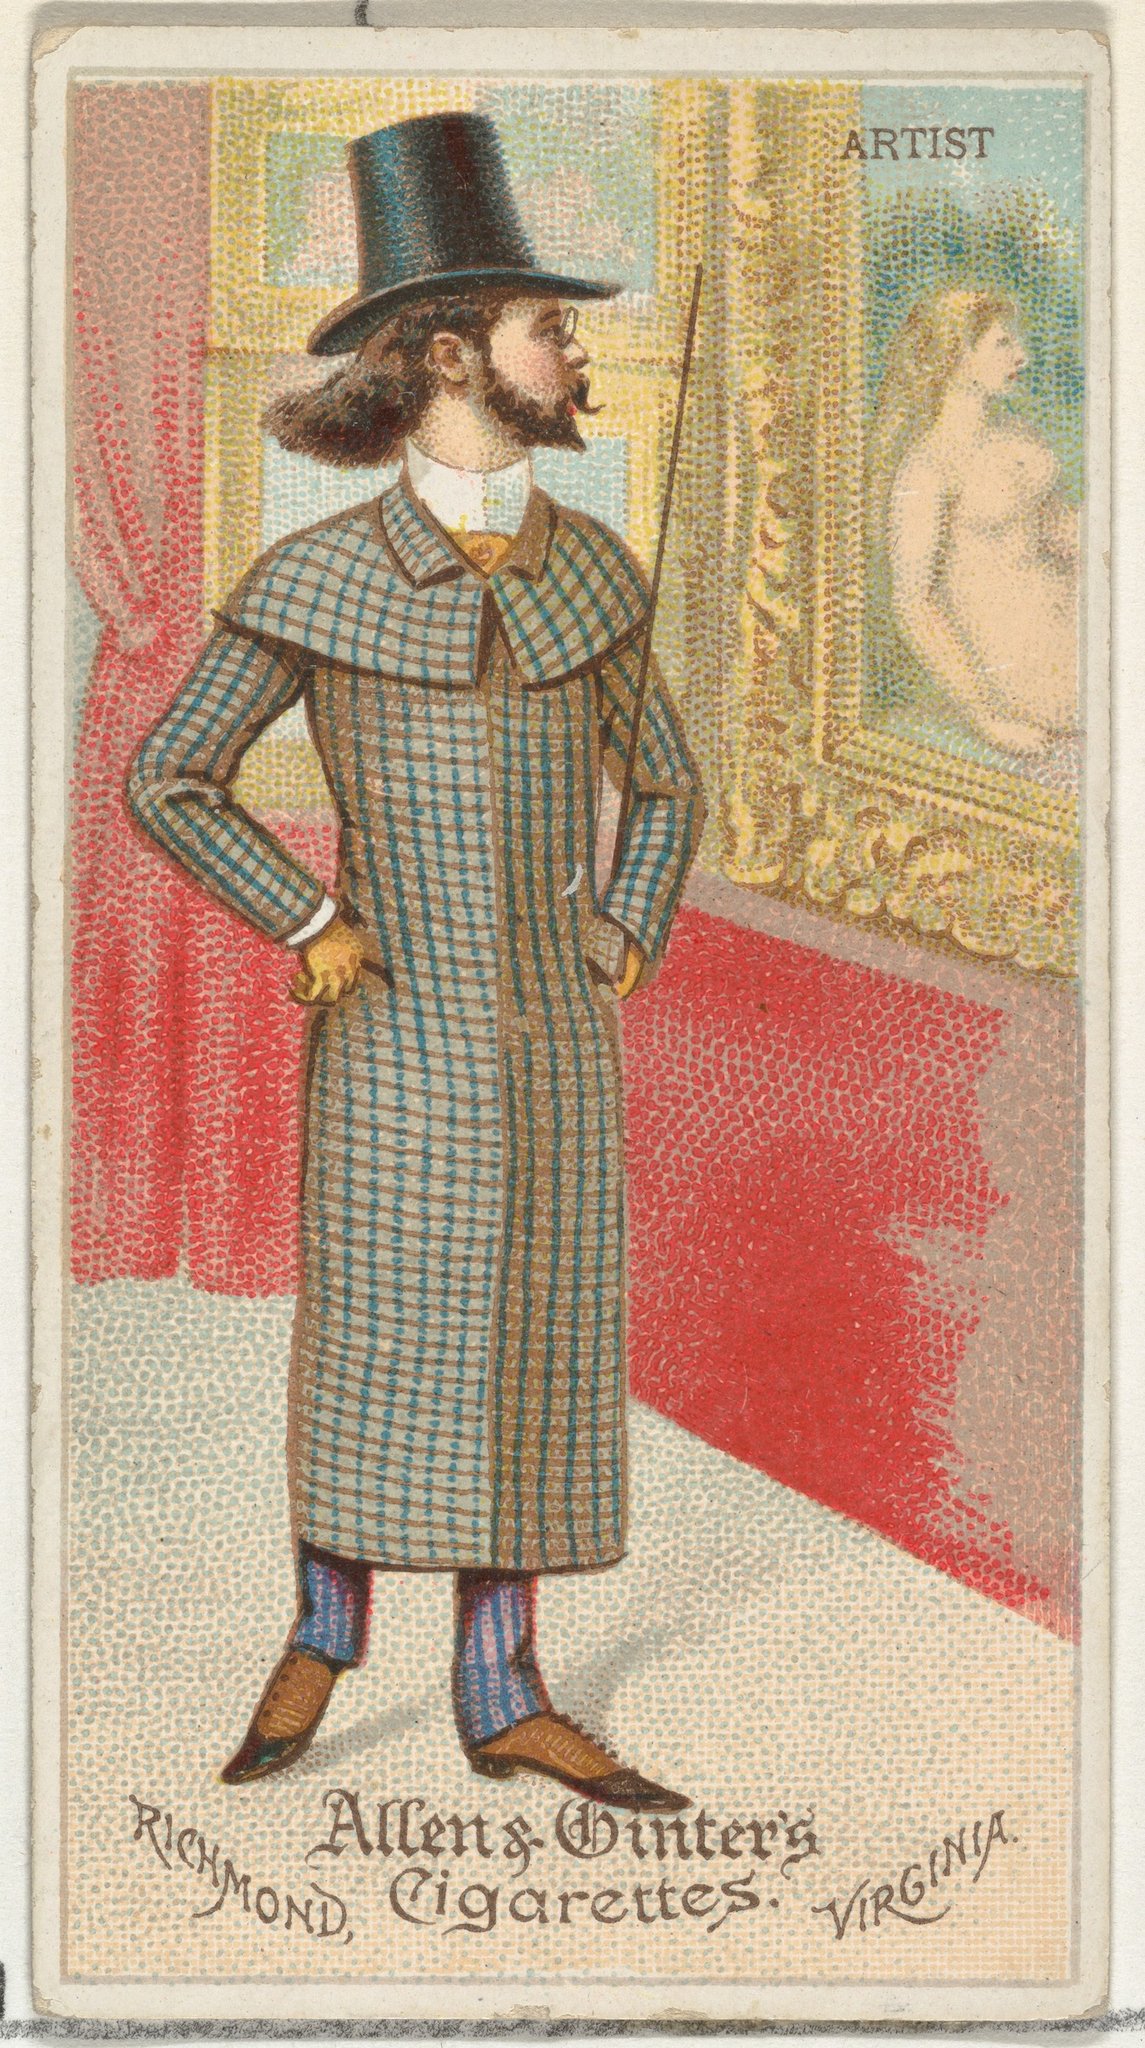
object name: print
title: Artist, from World's Dudes series (N31) for Allen & Ginter Cigarettes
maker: allen & ginter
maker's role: publisher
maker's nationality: american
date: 1888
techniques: color lithograph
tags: men,profiles,artists